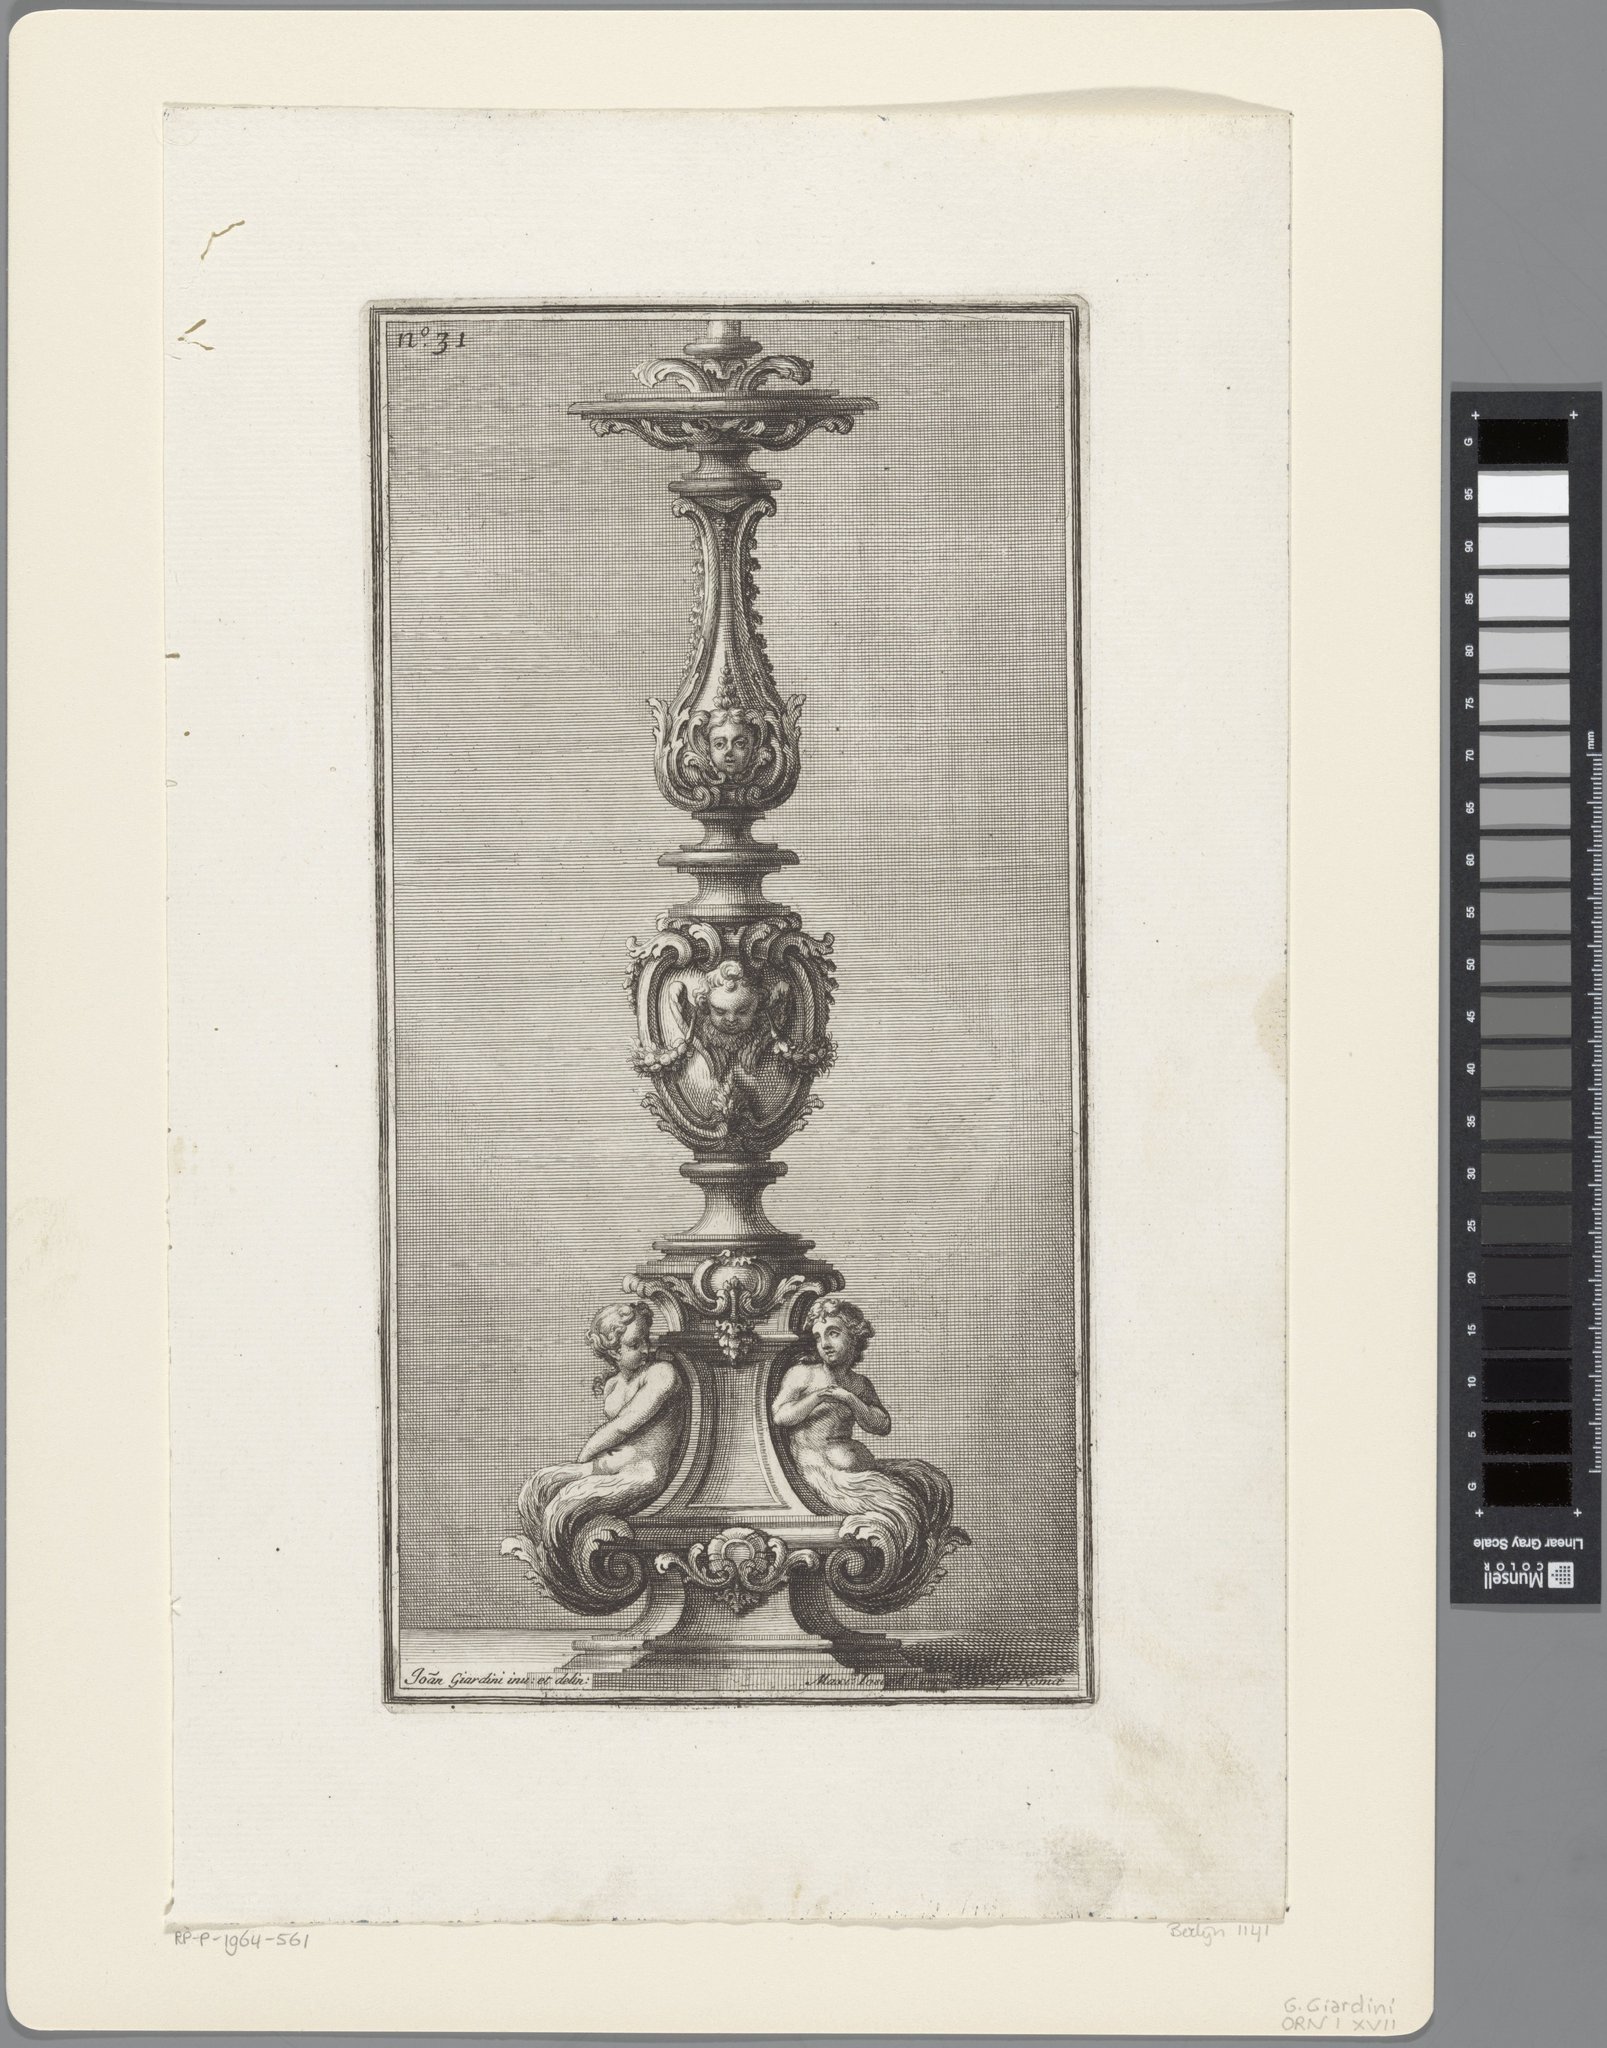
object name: ornament print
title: Disegni diversi inventati e delineati da Giovanni Giardini da Forlì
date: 1714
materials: paper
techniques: etching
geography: italy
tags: cherubs, i.e. children's heads with wings, foliage ~ ornament, chandelier, candelabrum, ornament ~ candelabrum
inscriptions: collector's mark: Lugt 2228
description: Prent maakt deel uit van een reeks van 100 ornamentprenten naar ontwerp van Giovanni Giardini.